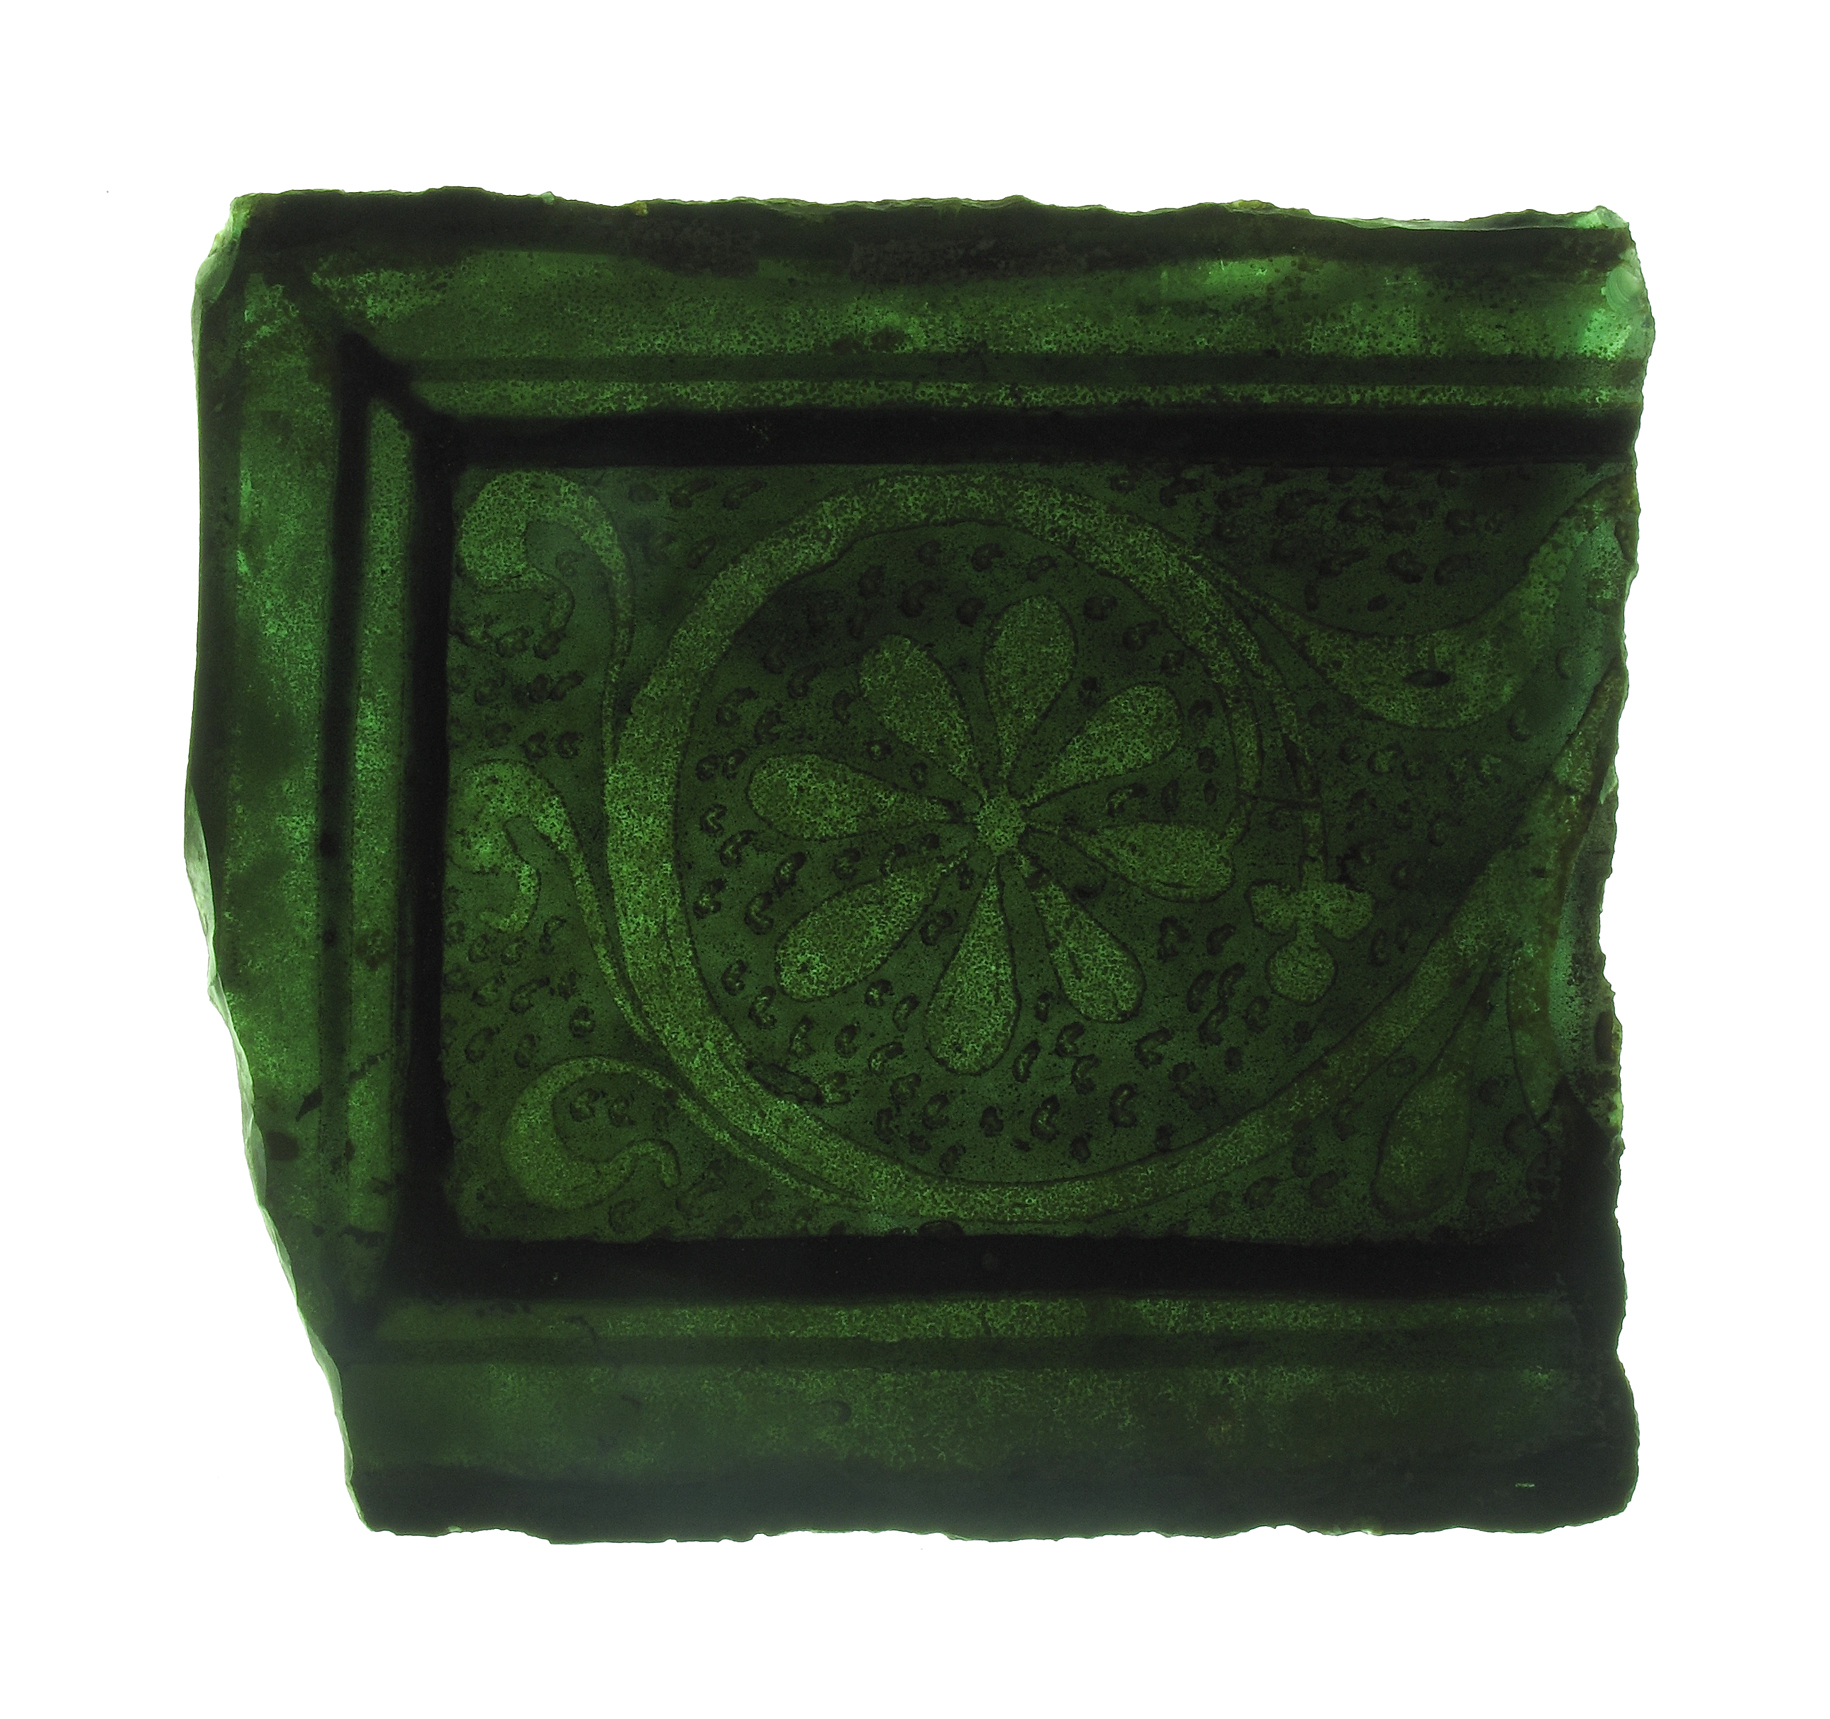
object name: fragment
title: Glass Fragment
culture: european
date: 1401-1500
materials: glass, metal